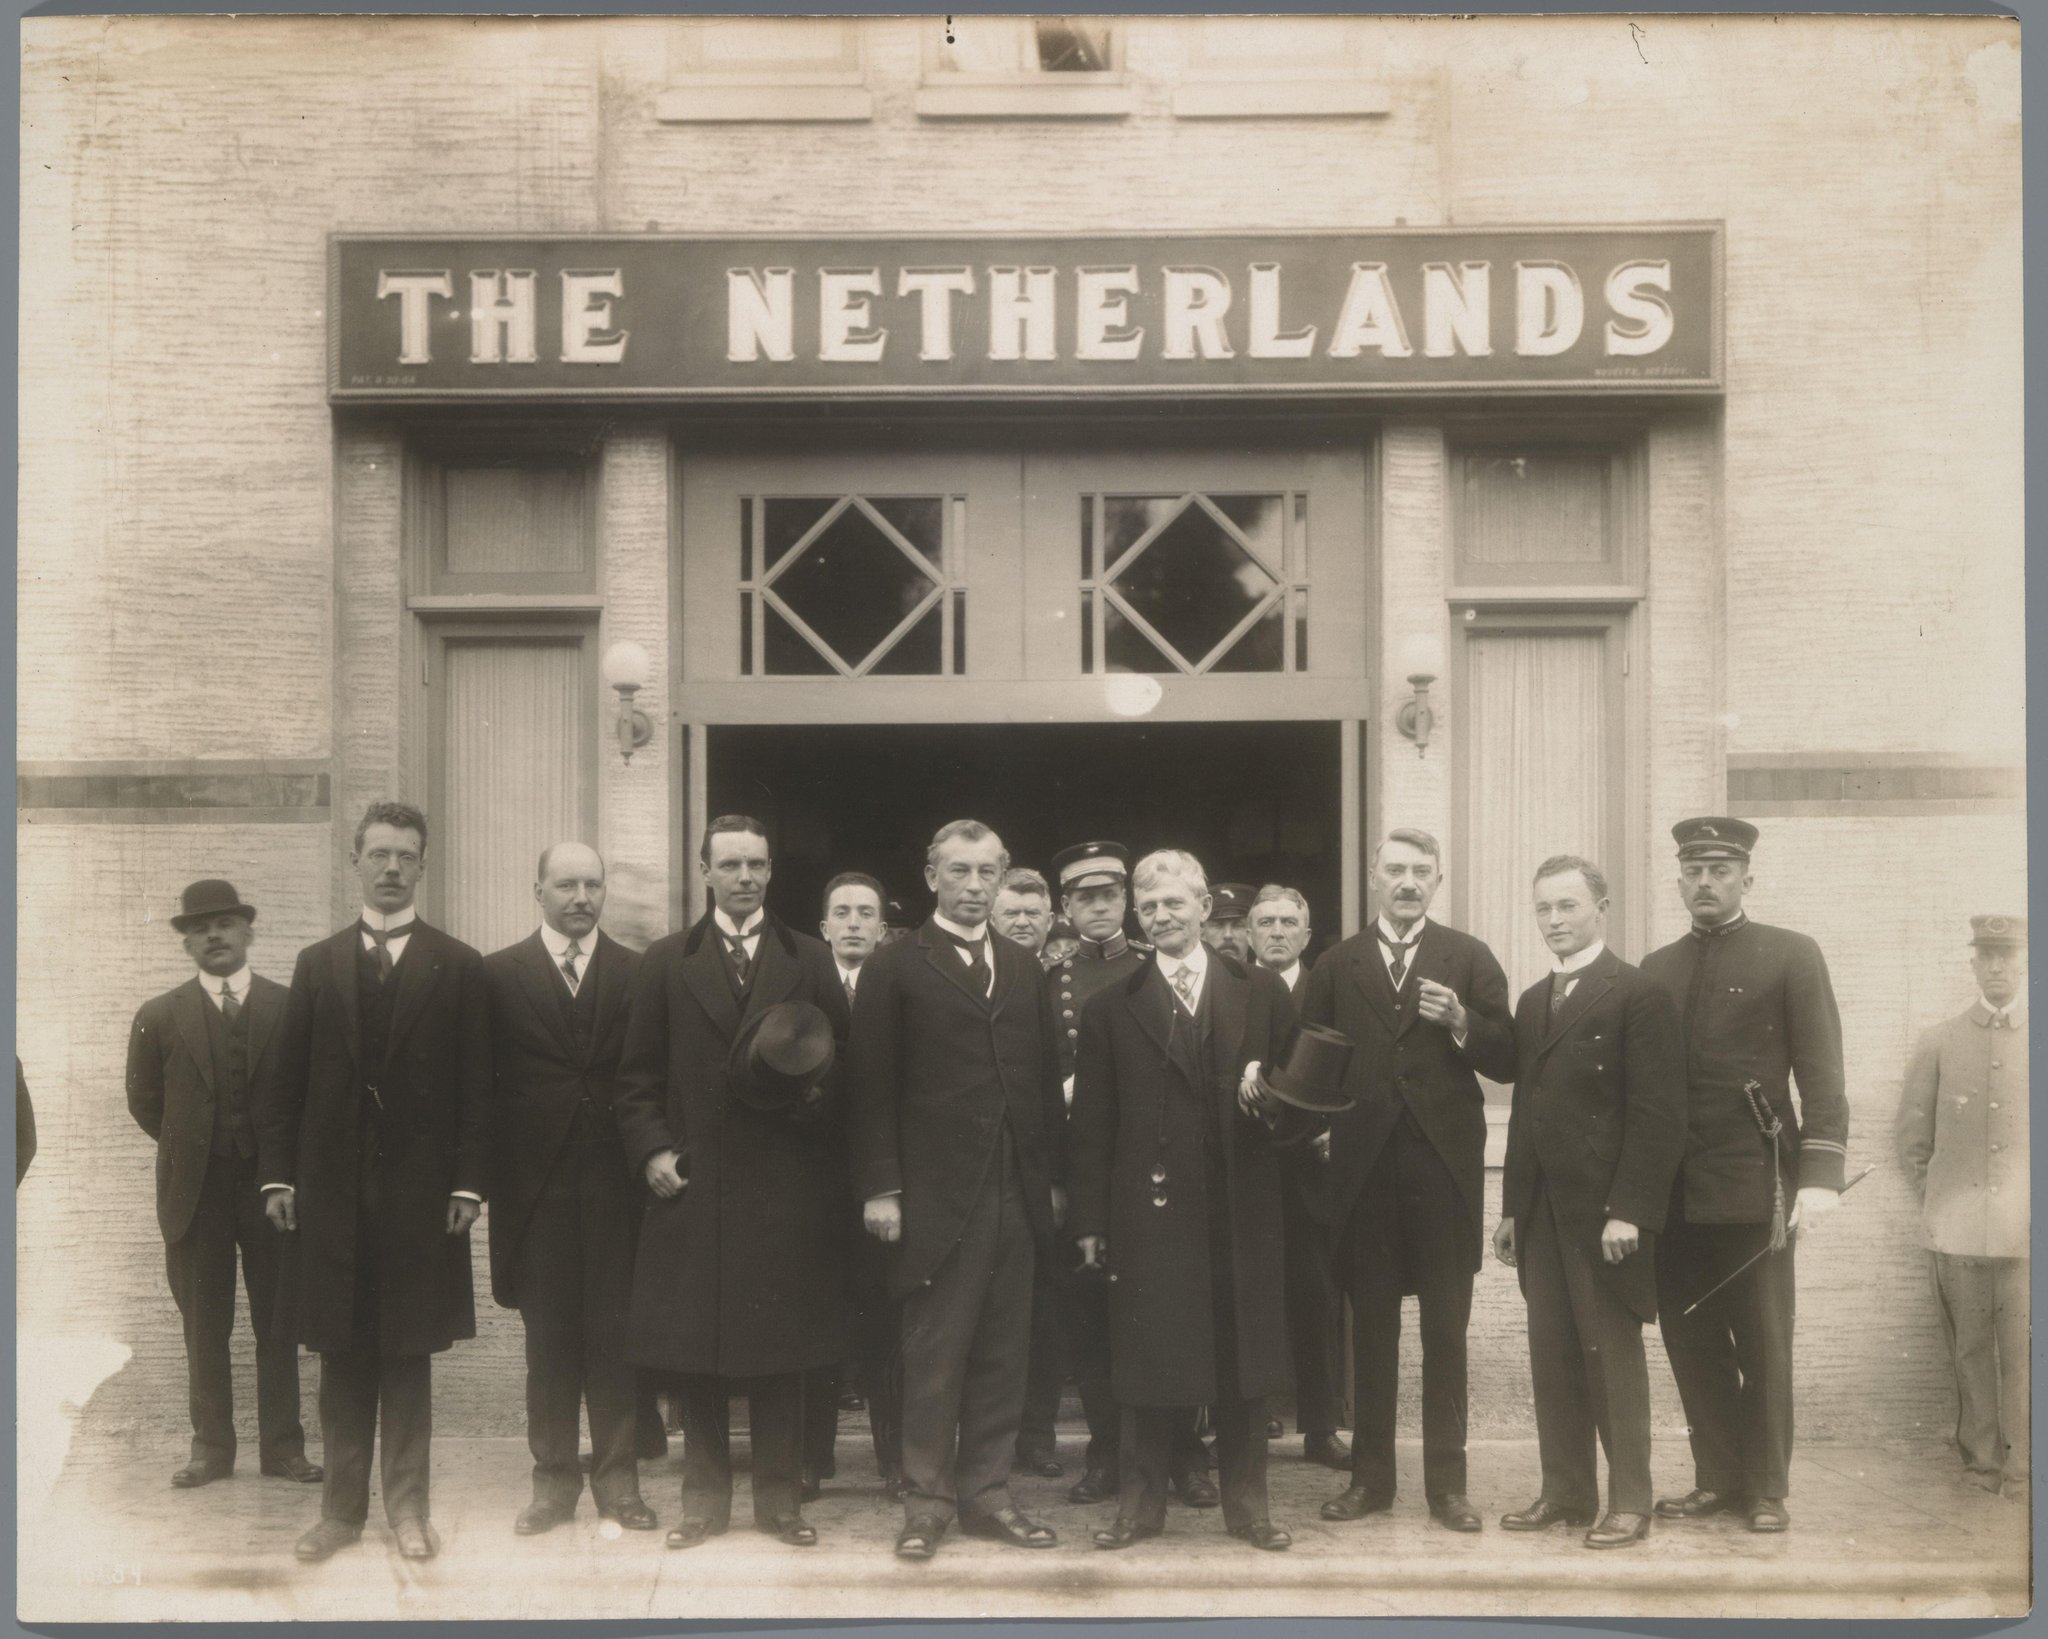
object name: photograph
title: Witsen met groep voor het Nederlands paviljoen (San Francisco)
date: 1860-1915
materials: paper, photographic support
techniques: gelatin silver print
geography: san francisco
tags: amsterdam, painter, print maker, draughtsman, willem witsen